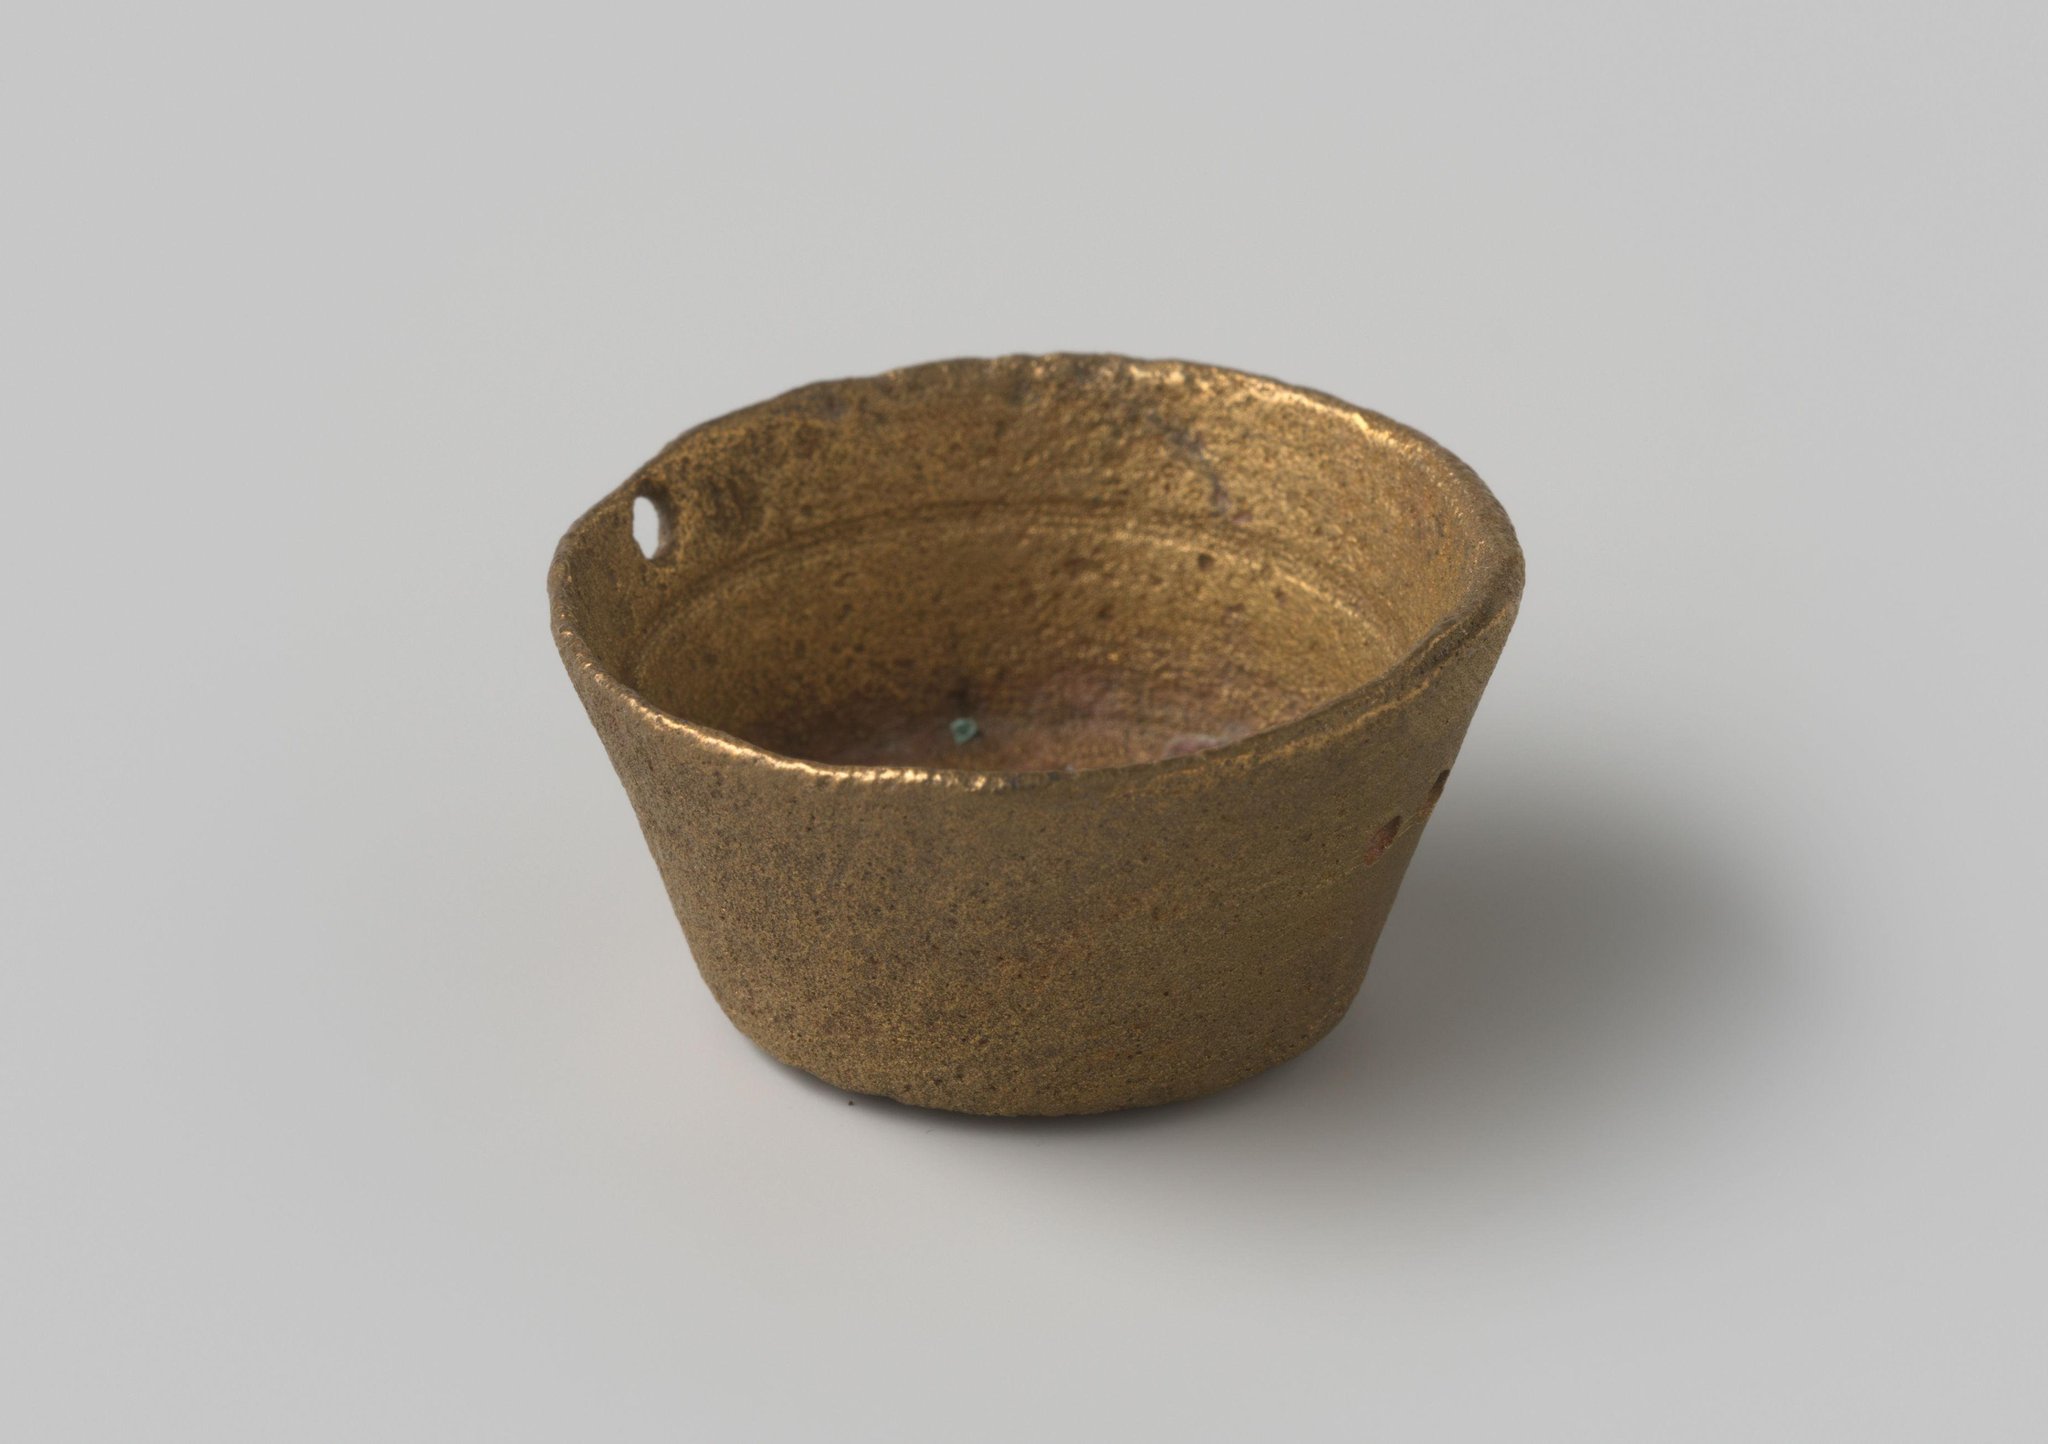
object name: sluitgewicht, pijlgewicht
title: Gewicht van sluitgewicht uit het wrak van de Oost-Indiëvaarder Hollandia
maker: Anonymous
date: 1700-1743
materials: copper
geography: netherlands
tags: verenigde oostindische compagnie, hollandia (schip), annet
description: Weight, cupweight, cup; id. NG 1980-27H2775, id. marks.